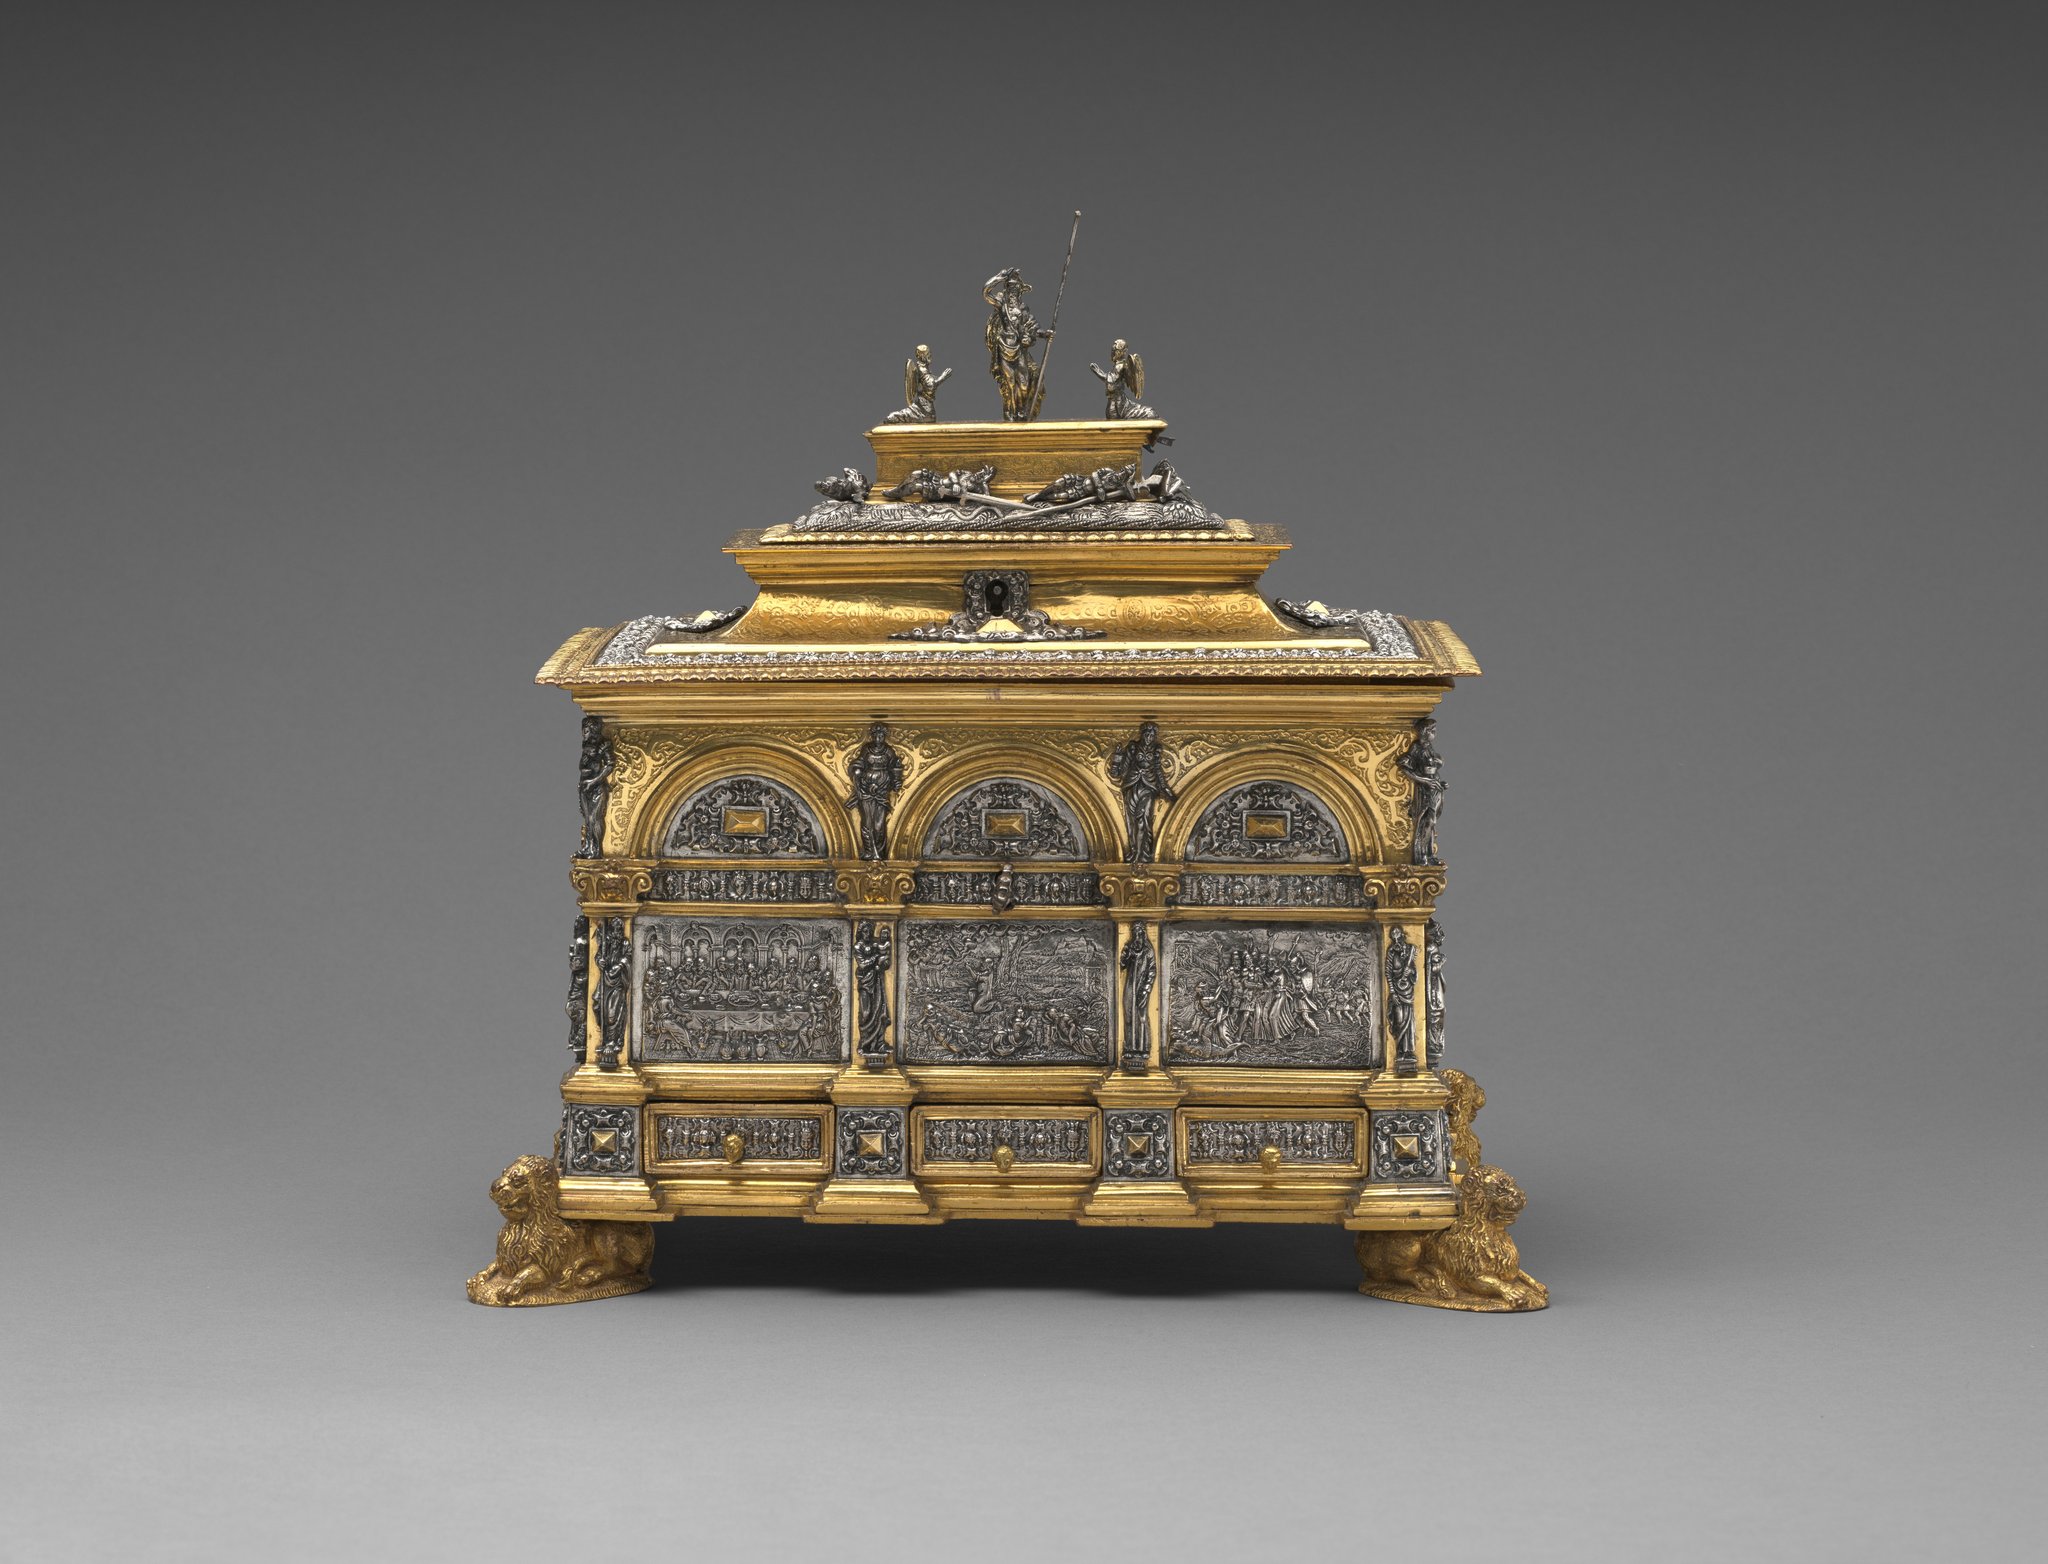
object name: casket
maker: wenzel jamnitzer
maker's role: maker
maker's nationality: german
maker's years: 1507-1585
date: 1567-1633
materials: metal, silver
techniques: gilding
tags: angels,christ,saints